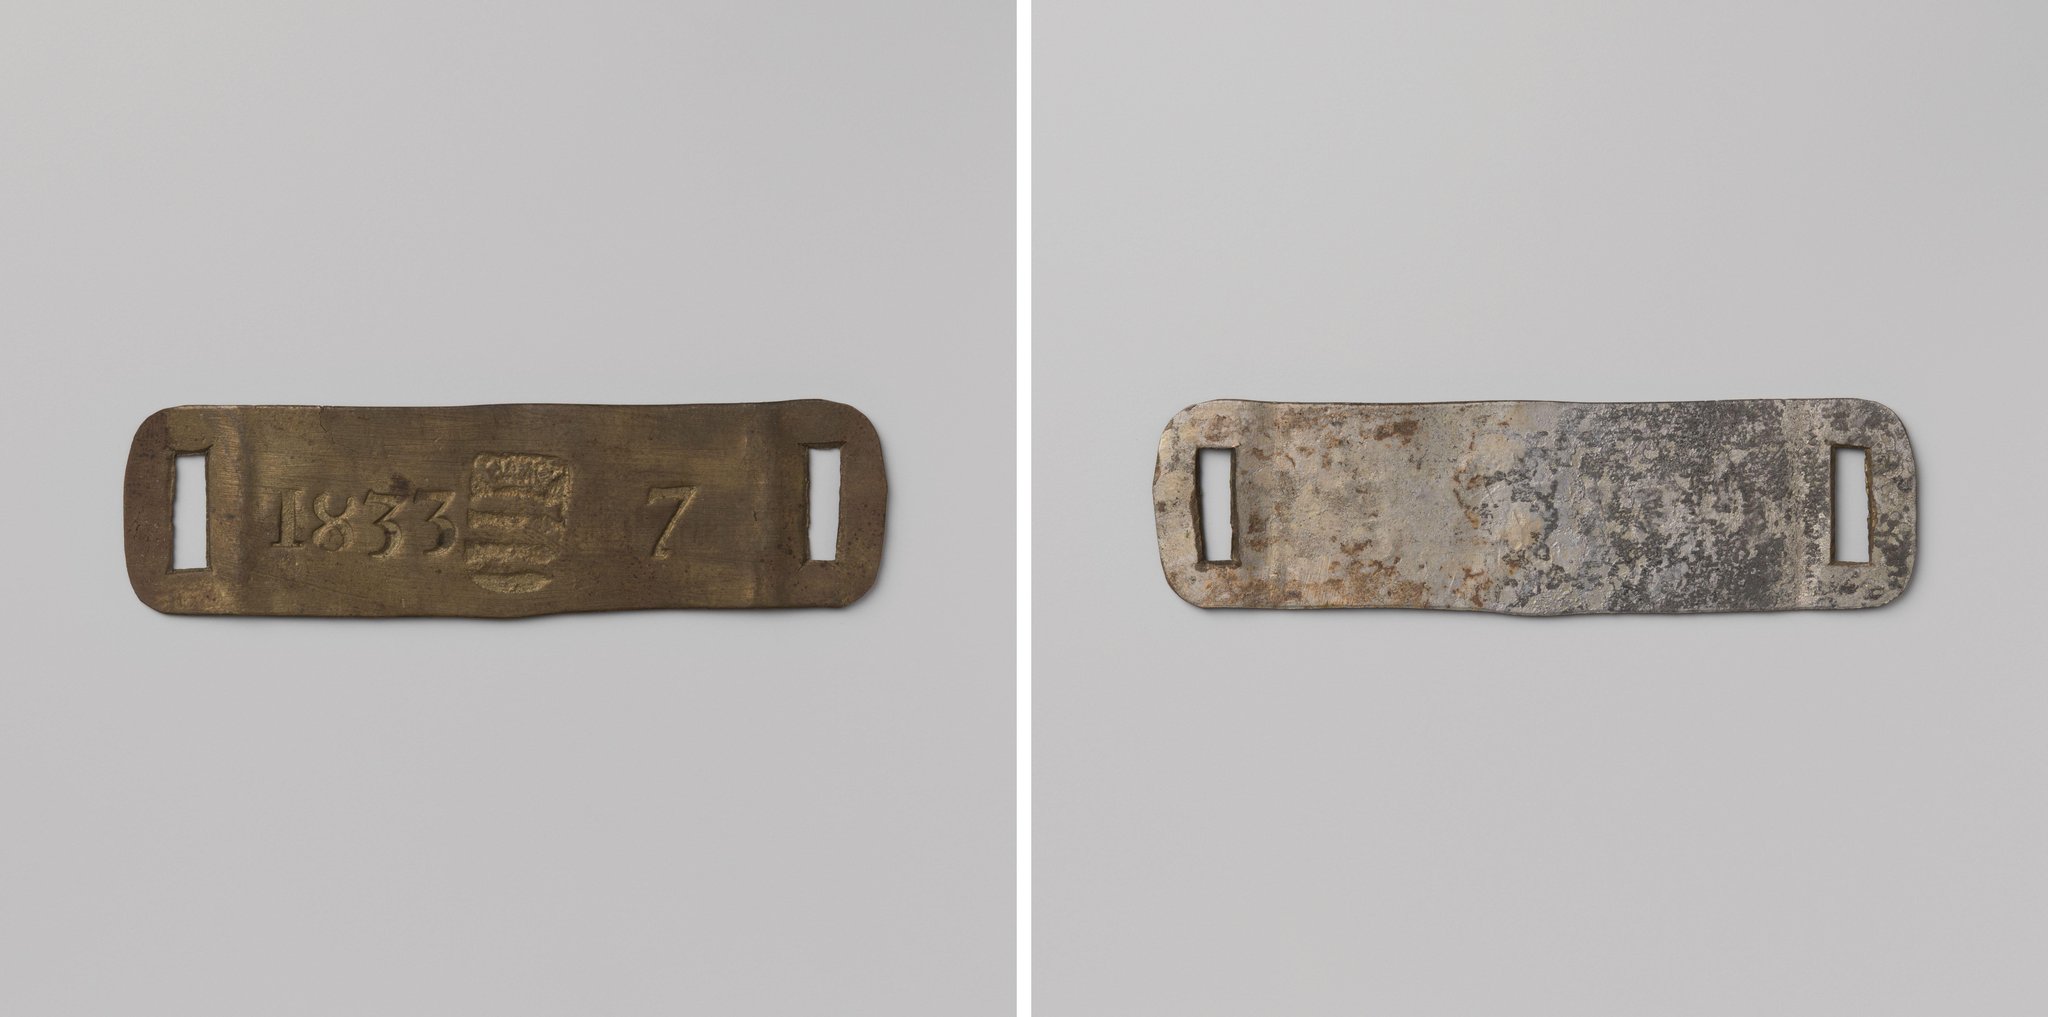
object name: hondenbelastingloodje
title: Stad Enkhuizen, loodje met no. 7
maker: Anonymous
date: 1833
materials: brass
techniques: striking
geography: enkhuizen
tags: enkhuizen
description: eenzijdig, staafvormig loodje met rechthoekige uitsparingen in beide uiteinden. Voorzijde: wapenschild met ter linkerzijde jaartal, ter rechterzijde cijfer 7. Keerzijde: blanco